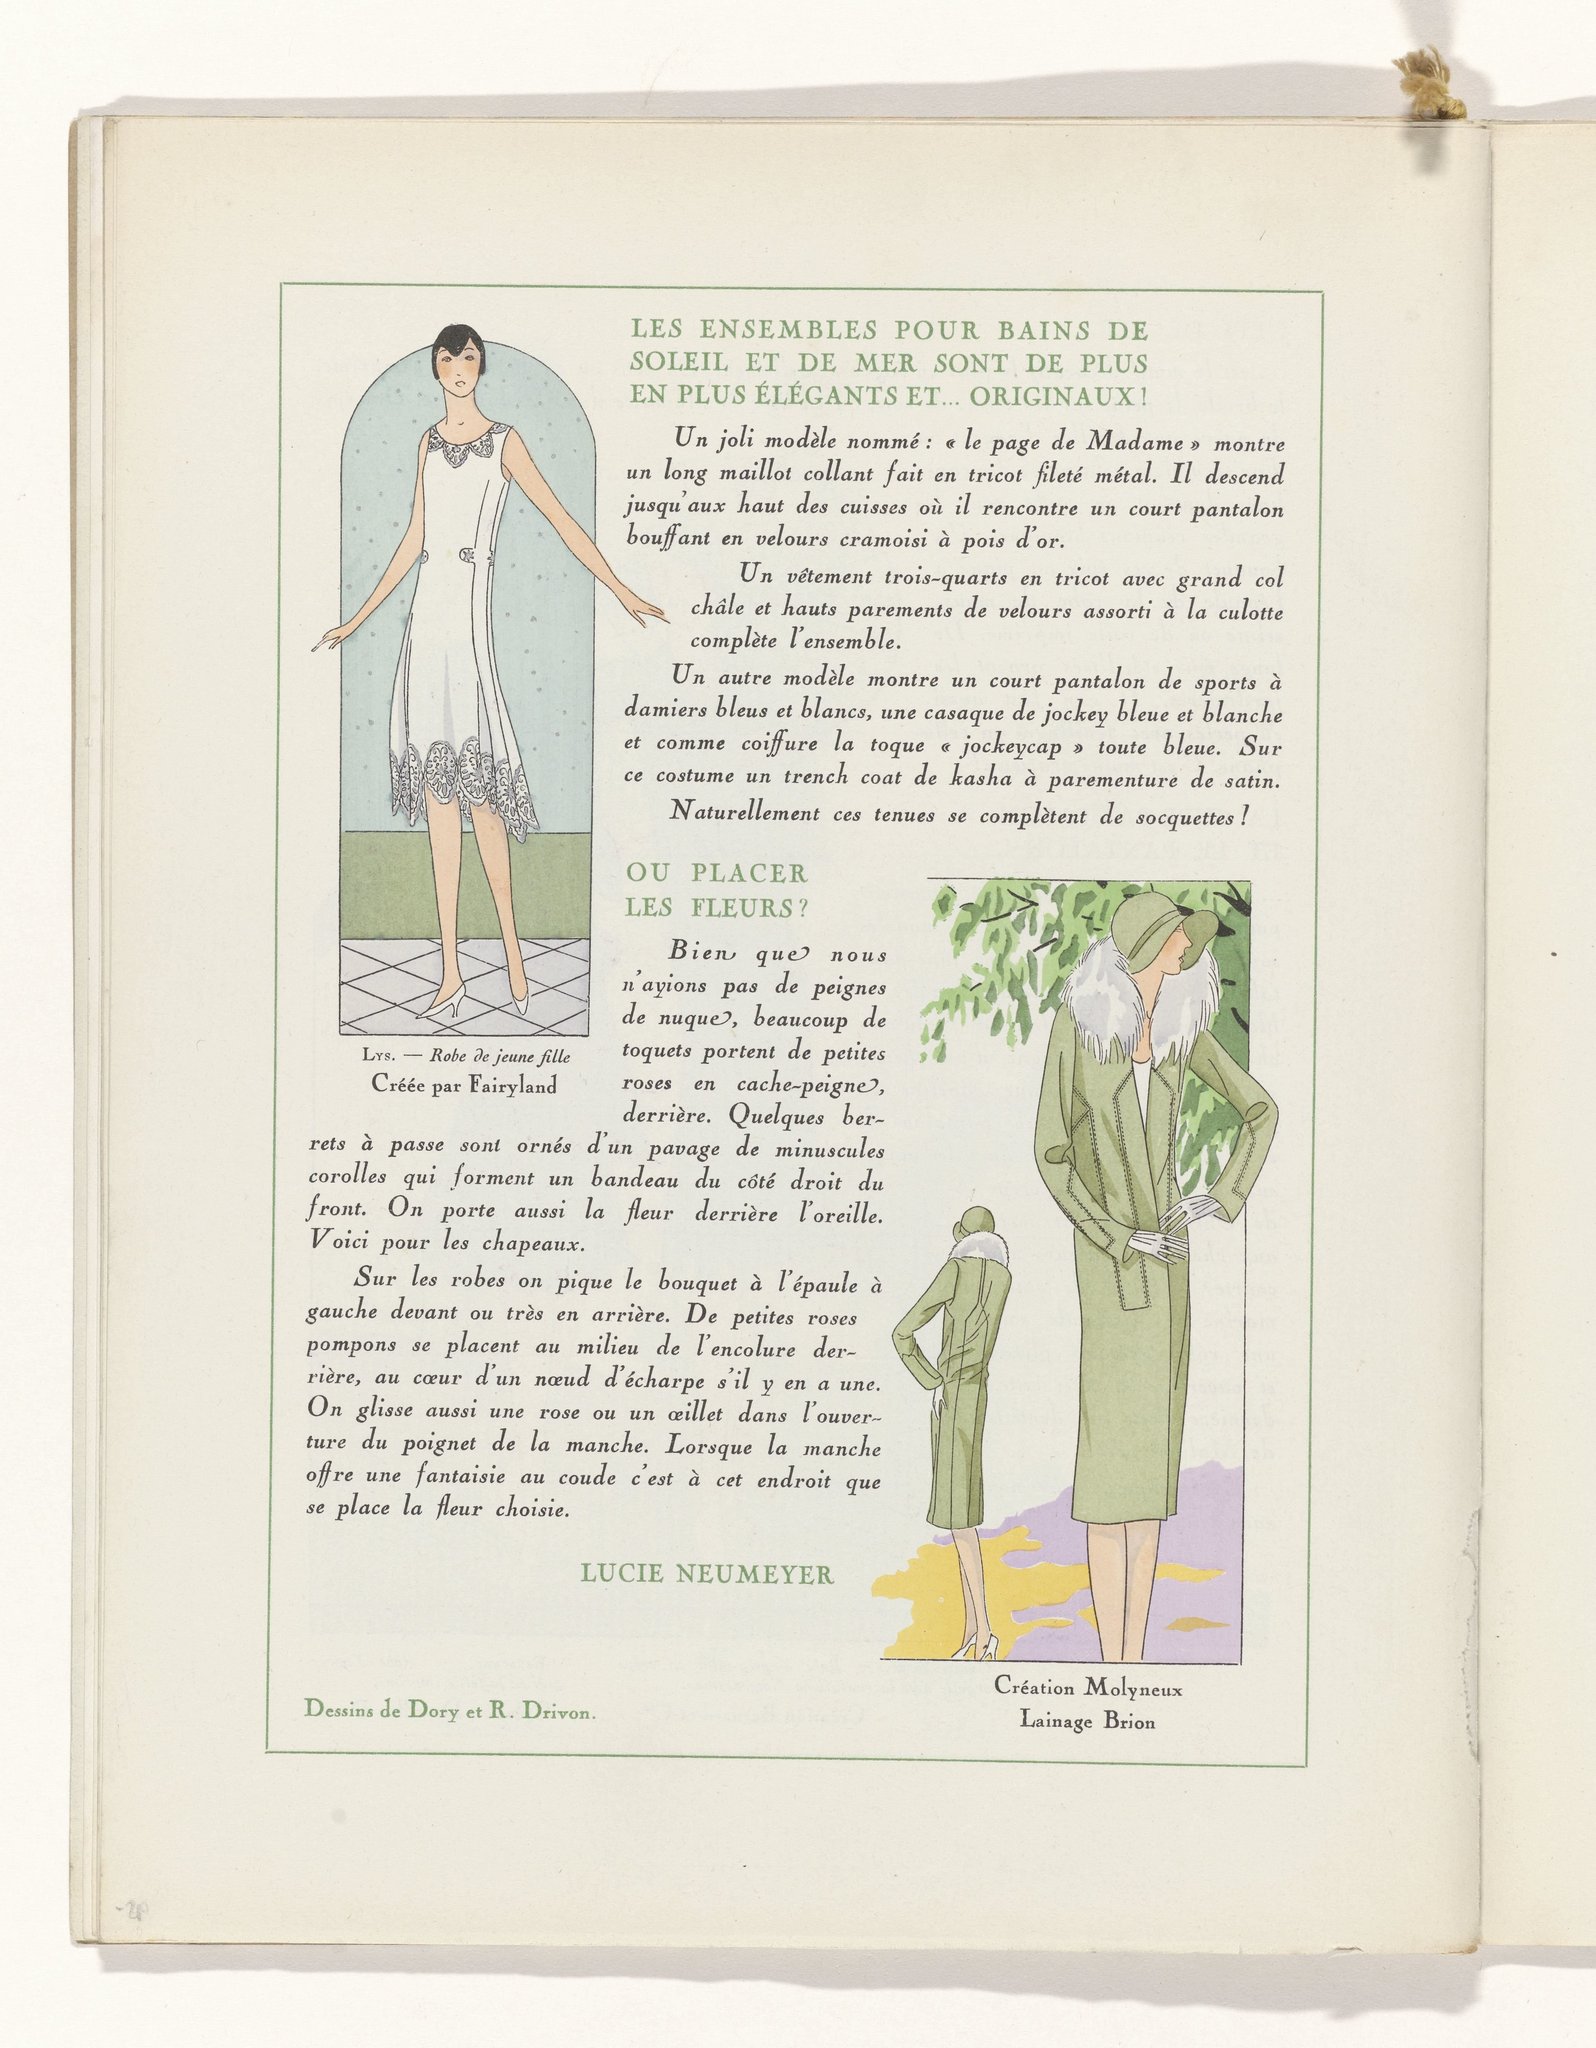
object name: fashion print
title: Art - Goût - Beauté, Feuillets de l' élégance féminine, Juin 1929, No. 106, 9e Année, p.21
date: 1929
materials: paper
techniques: hand coloring, lithograph, pochoir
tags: coat (+ women's clothes), fashion plates, gloves, mittens, etc. (+ women's clothes), dress, gown (+ women's clothes), neck-gear: collar (+ fur used for clothes)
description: Tekst over zomerkleding. Illustraties: linksboven: witte jurk voor een jonge vrouw, ontworpen door Fairyland. Rechtsonder: groene mantel van wol met bontkraag, van Molyneux. Pagina uit het modetijdschrift Art-Goût-Beauté (1920-1933).